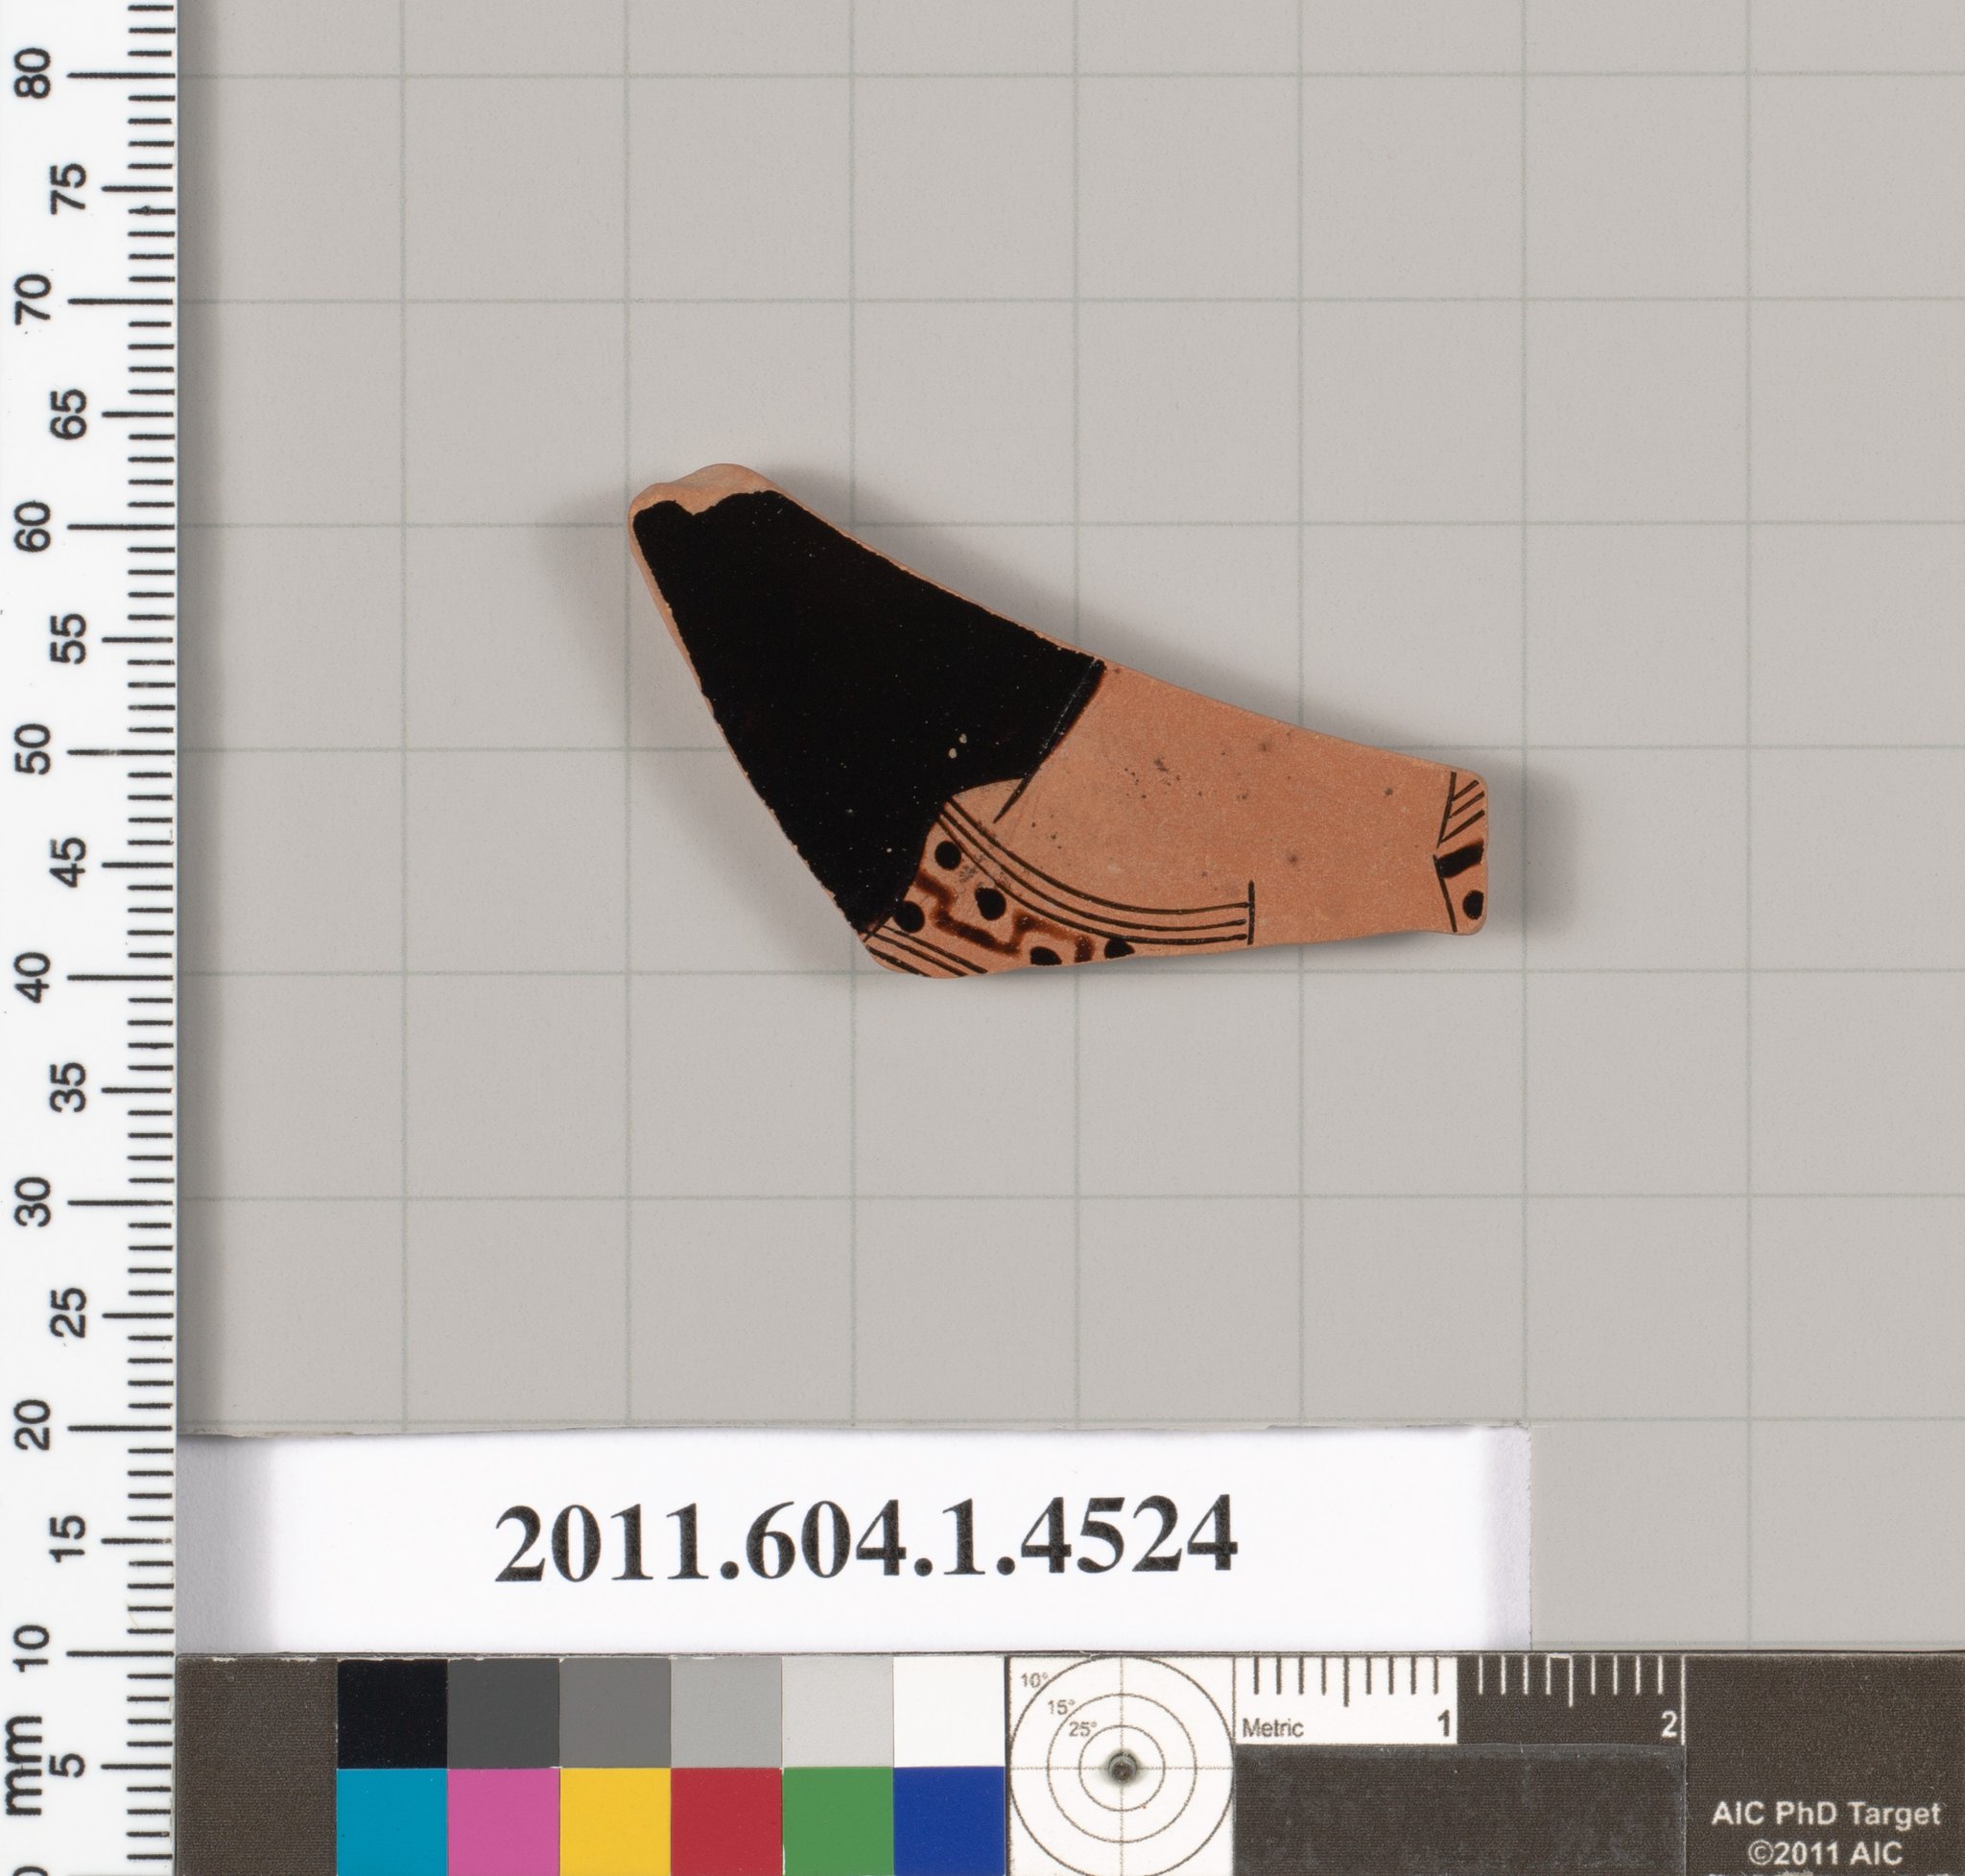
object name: kylix fragment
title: Terracotta fragment of a kylix (drinking cup)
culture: greek, attic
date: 500-480 BCE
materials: terracotta